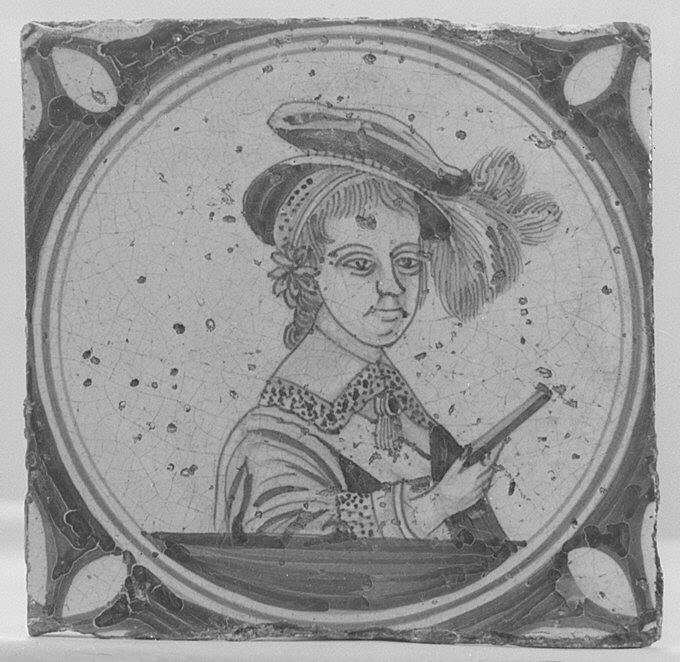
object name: tile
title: Prince Frederik Hendrik of Orange (1584–1647) as a child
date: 1801-1900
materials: earthenware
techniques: glazing